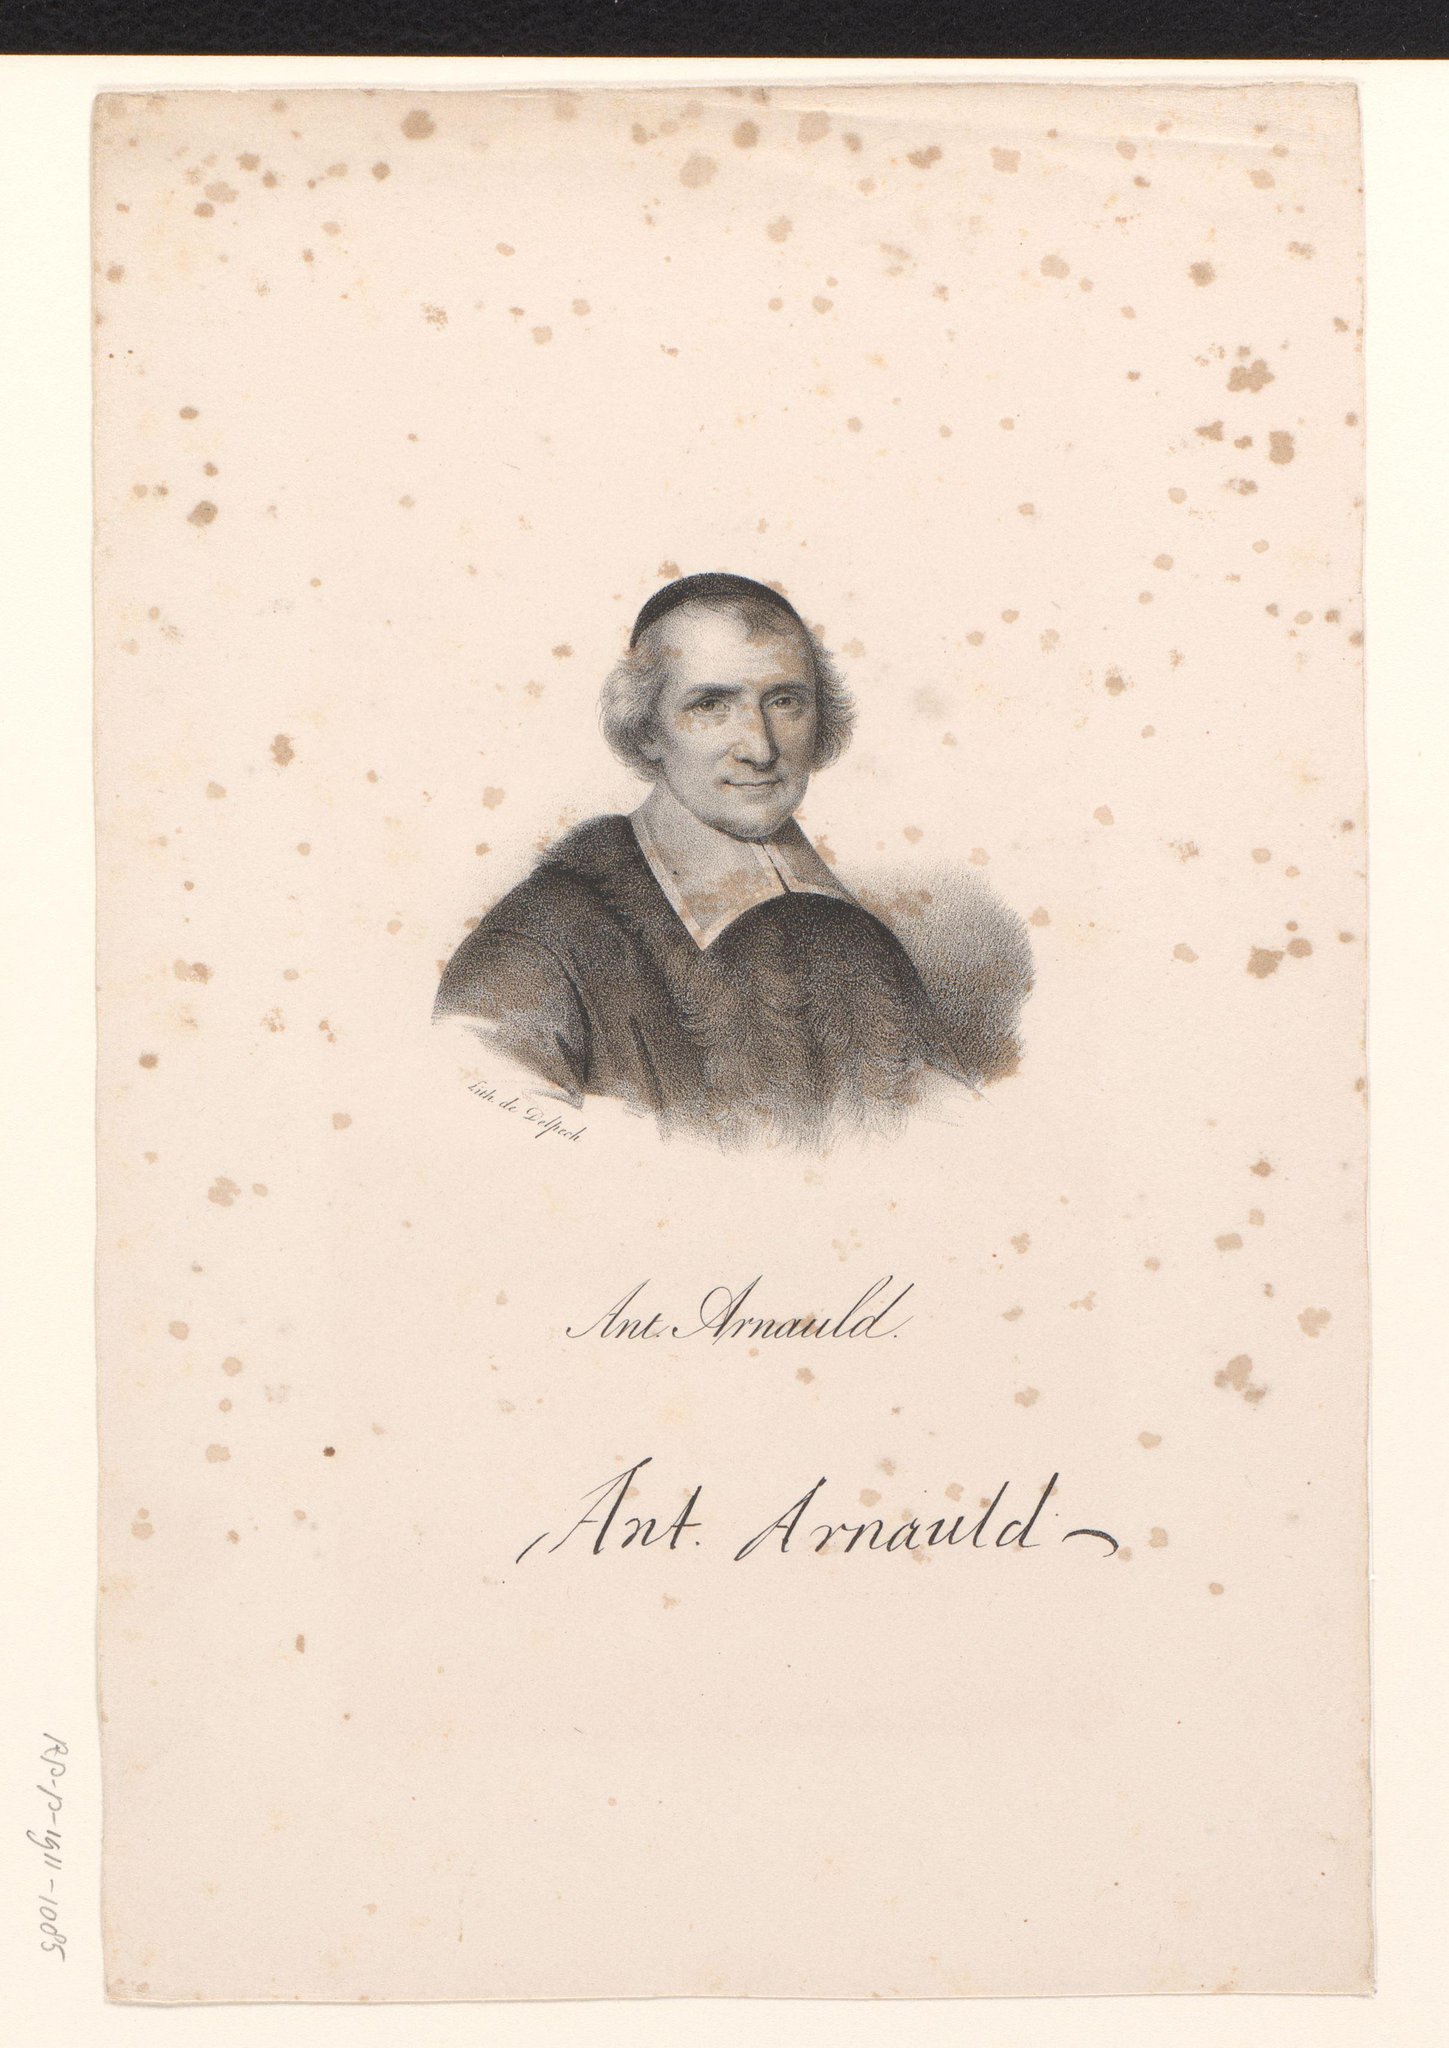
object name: print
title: Portret van Antoine Arnauld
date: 1818-1842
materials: paper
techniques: lithograph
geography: paris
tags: paris, brussels, historical persons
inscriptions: collector's mark: Lugt 2228a